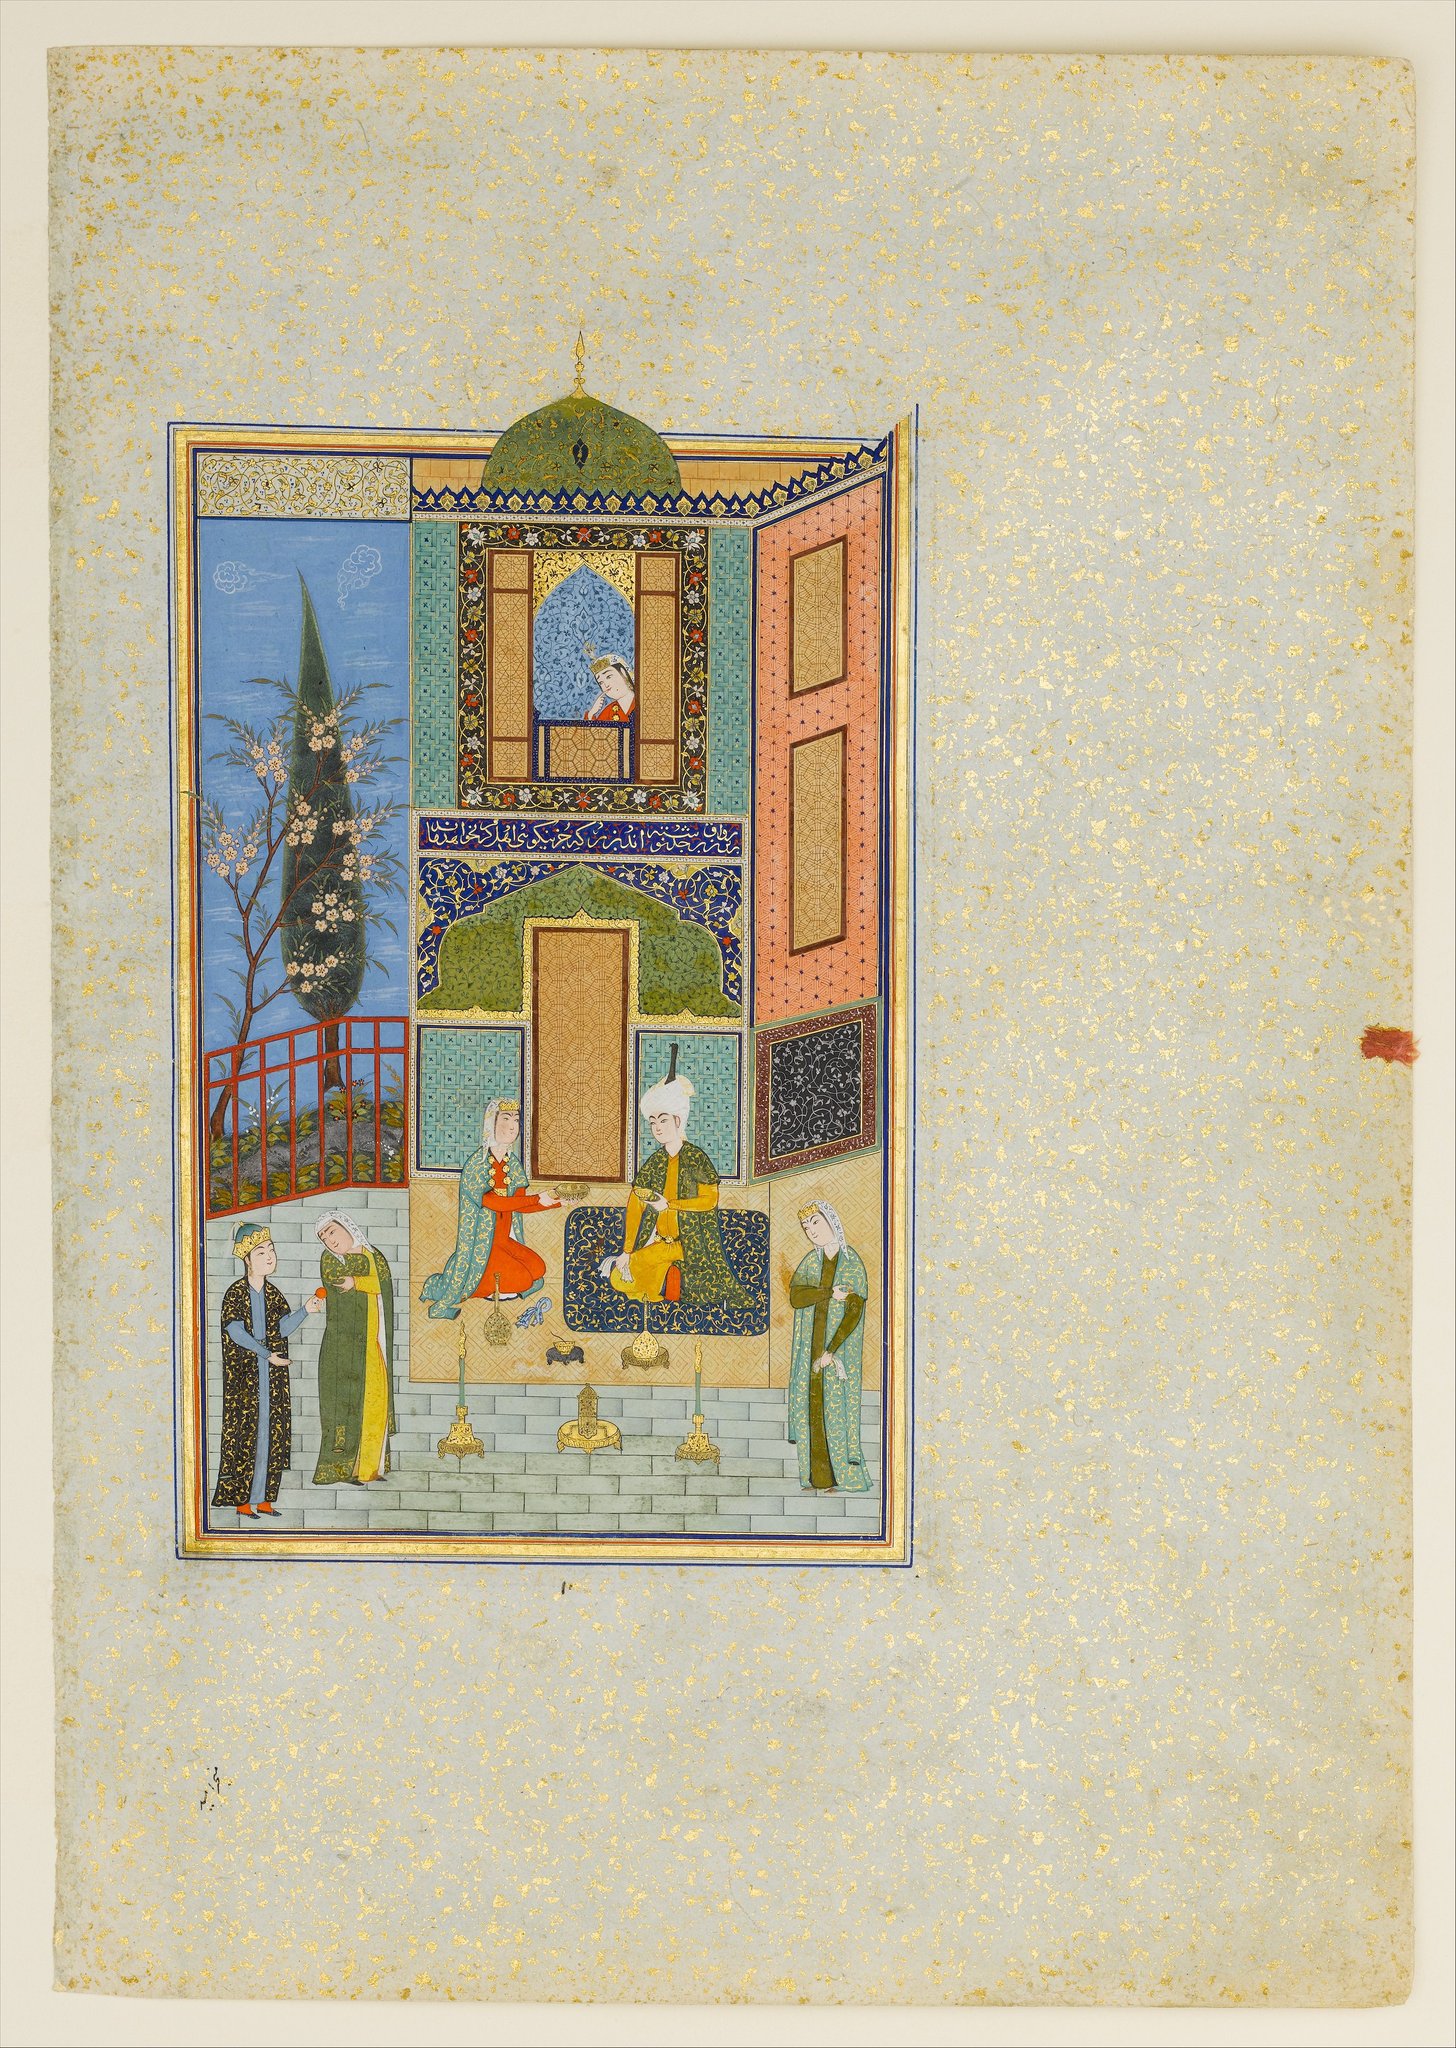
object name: folio from an illustrated manuscript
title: "Bahram Gur in the Green Palace on Monday", Folio 224 from a Khamsa (Quintet) of Nizami of Ganja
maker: nizami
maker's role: author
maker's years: 1141-1209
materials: gold, ink, paper, silver, watercolor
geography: afghanistan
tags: princesses,men,women